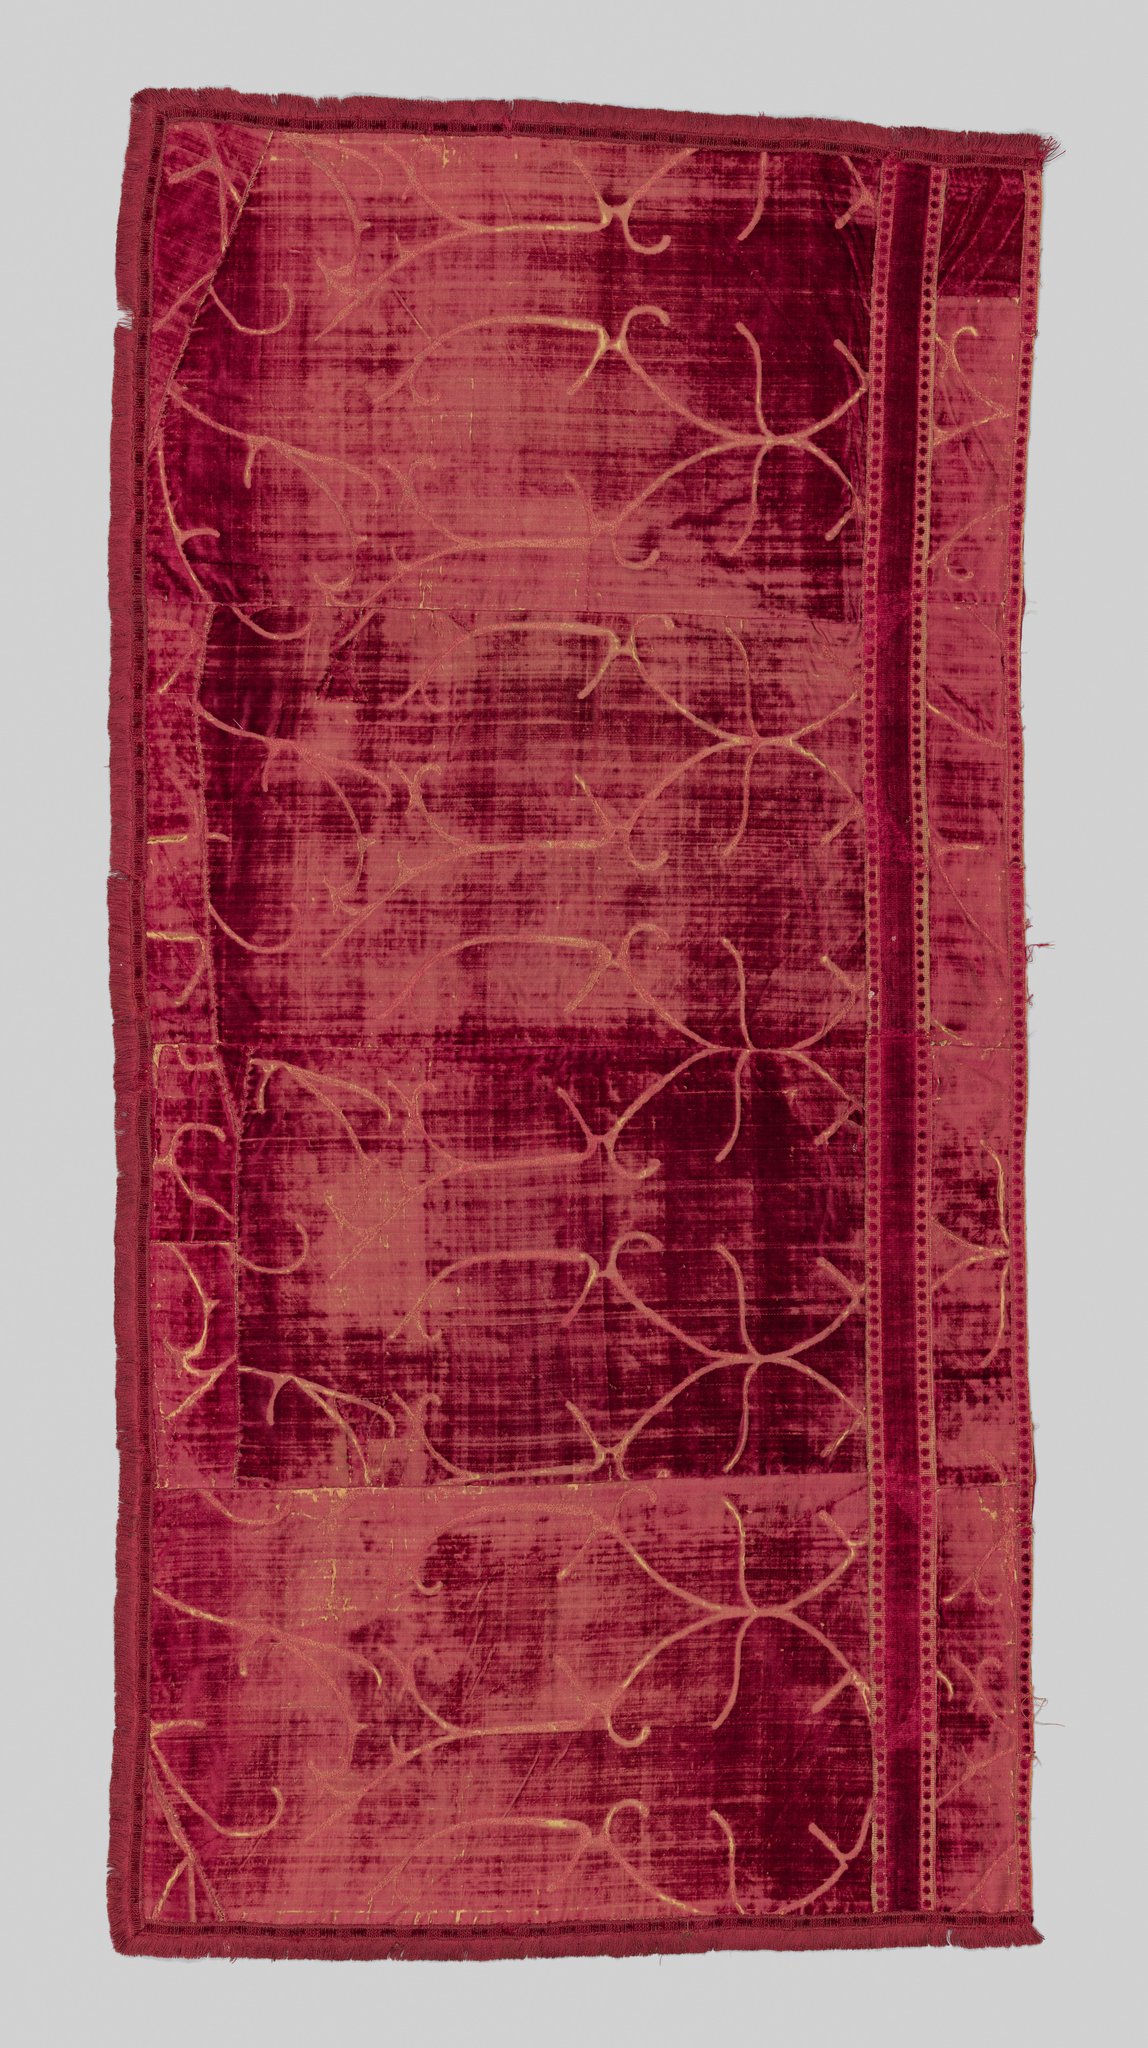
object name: antependium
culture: italian or spanish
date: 1401-1500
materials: silk